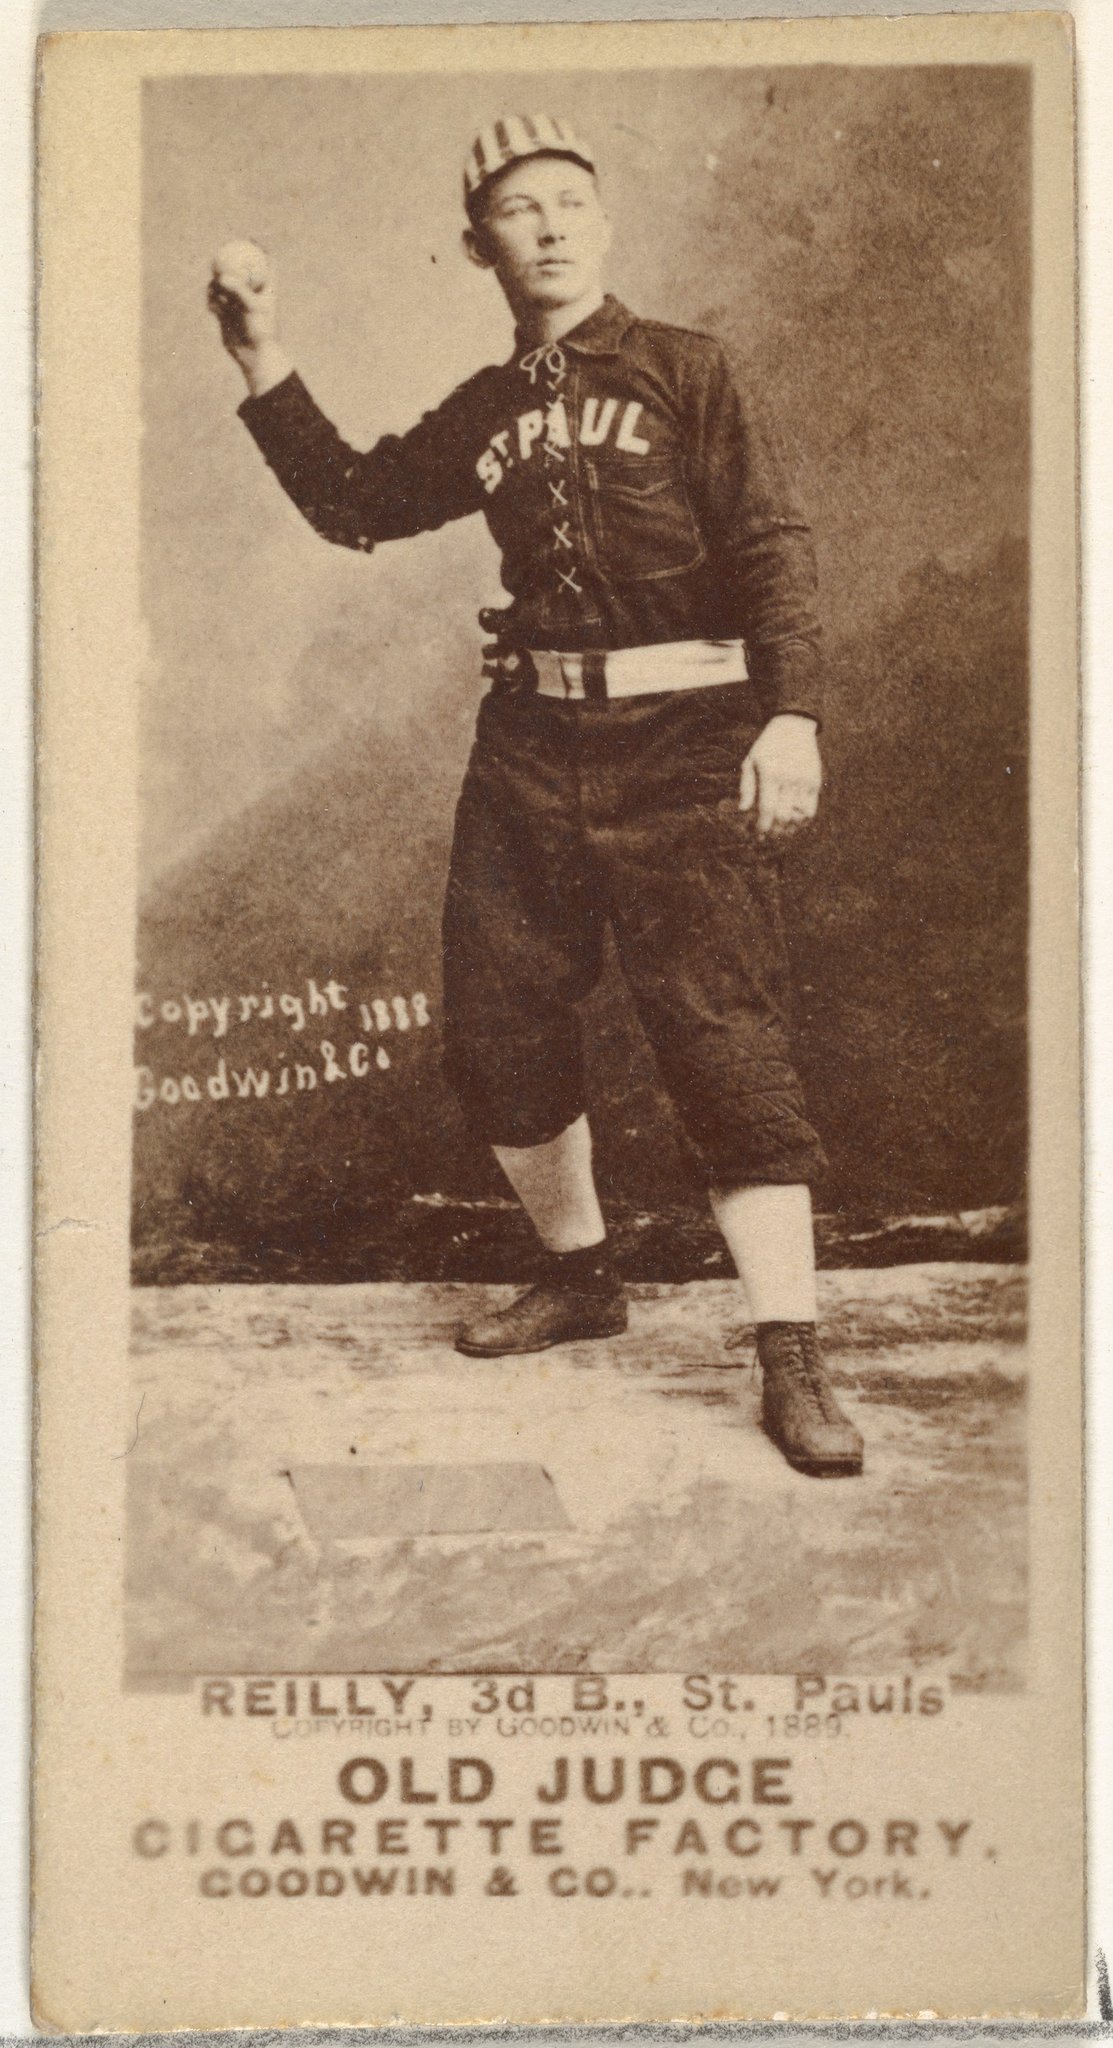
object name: baseball card, photograph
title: Charles Thomas "Charlie" Reilly, 3rd Base, St. Paul Apostles, from the Old Judge series (N172) for Old Judge Cigarettes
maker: goodwin & company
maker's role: publisher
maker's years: 1850-1950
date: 1889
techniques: albumen silver print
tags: men,portraits,baseball,athletes